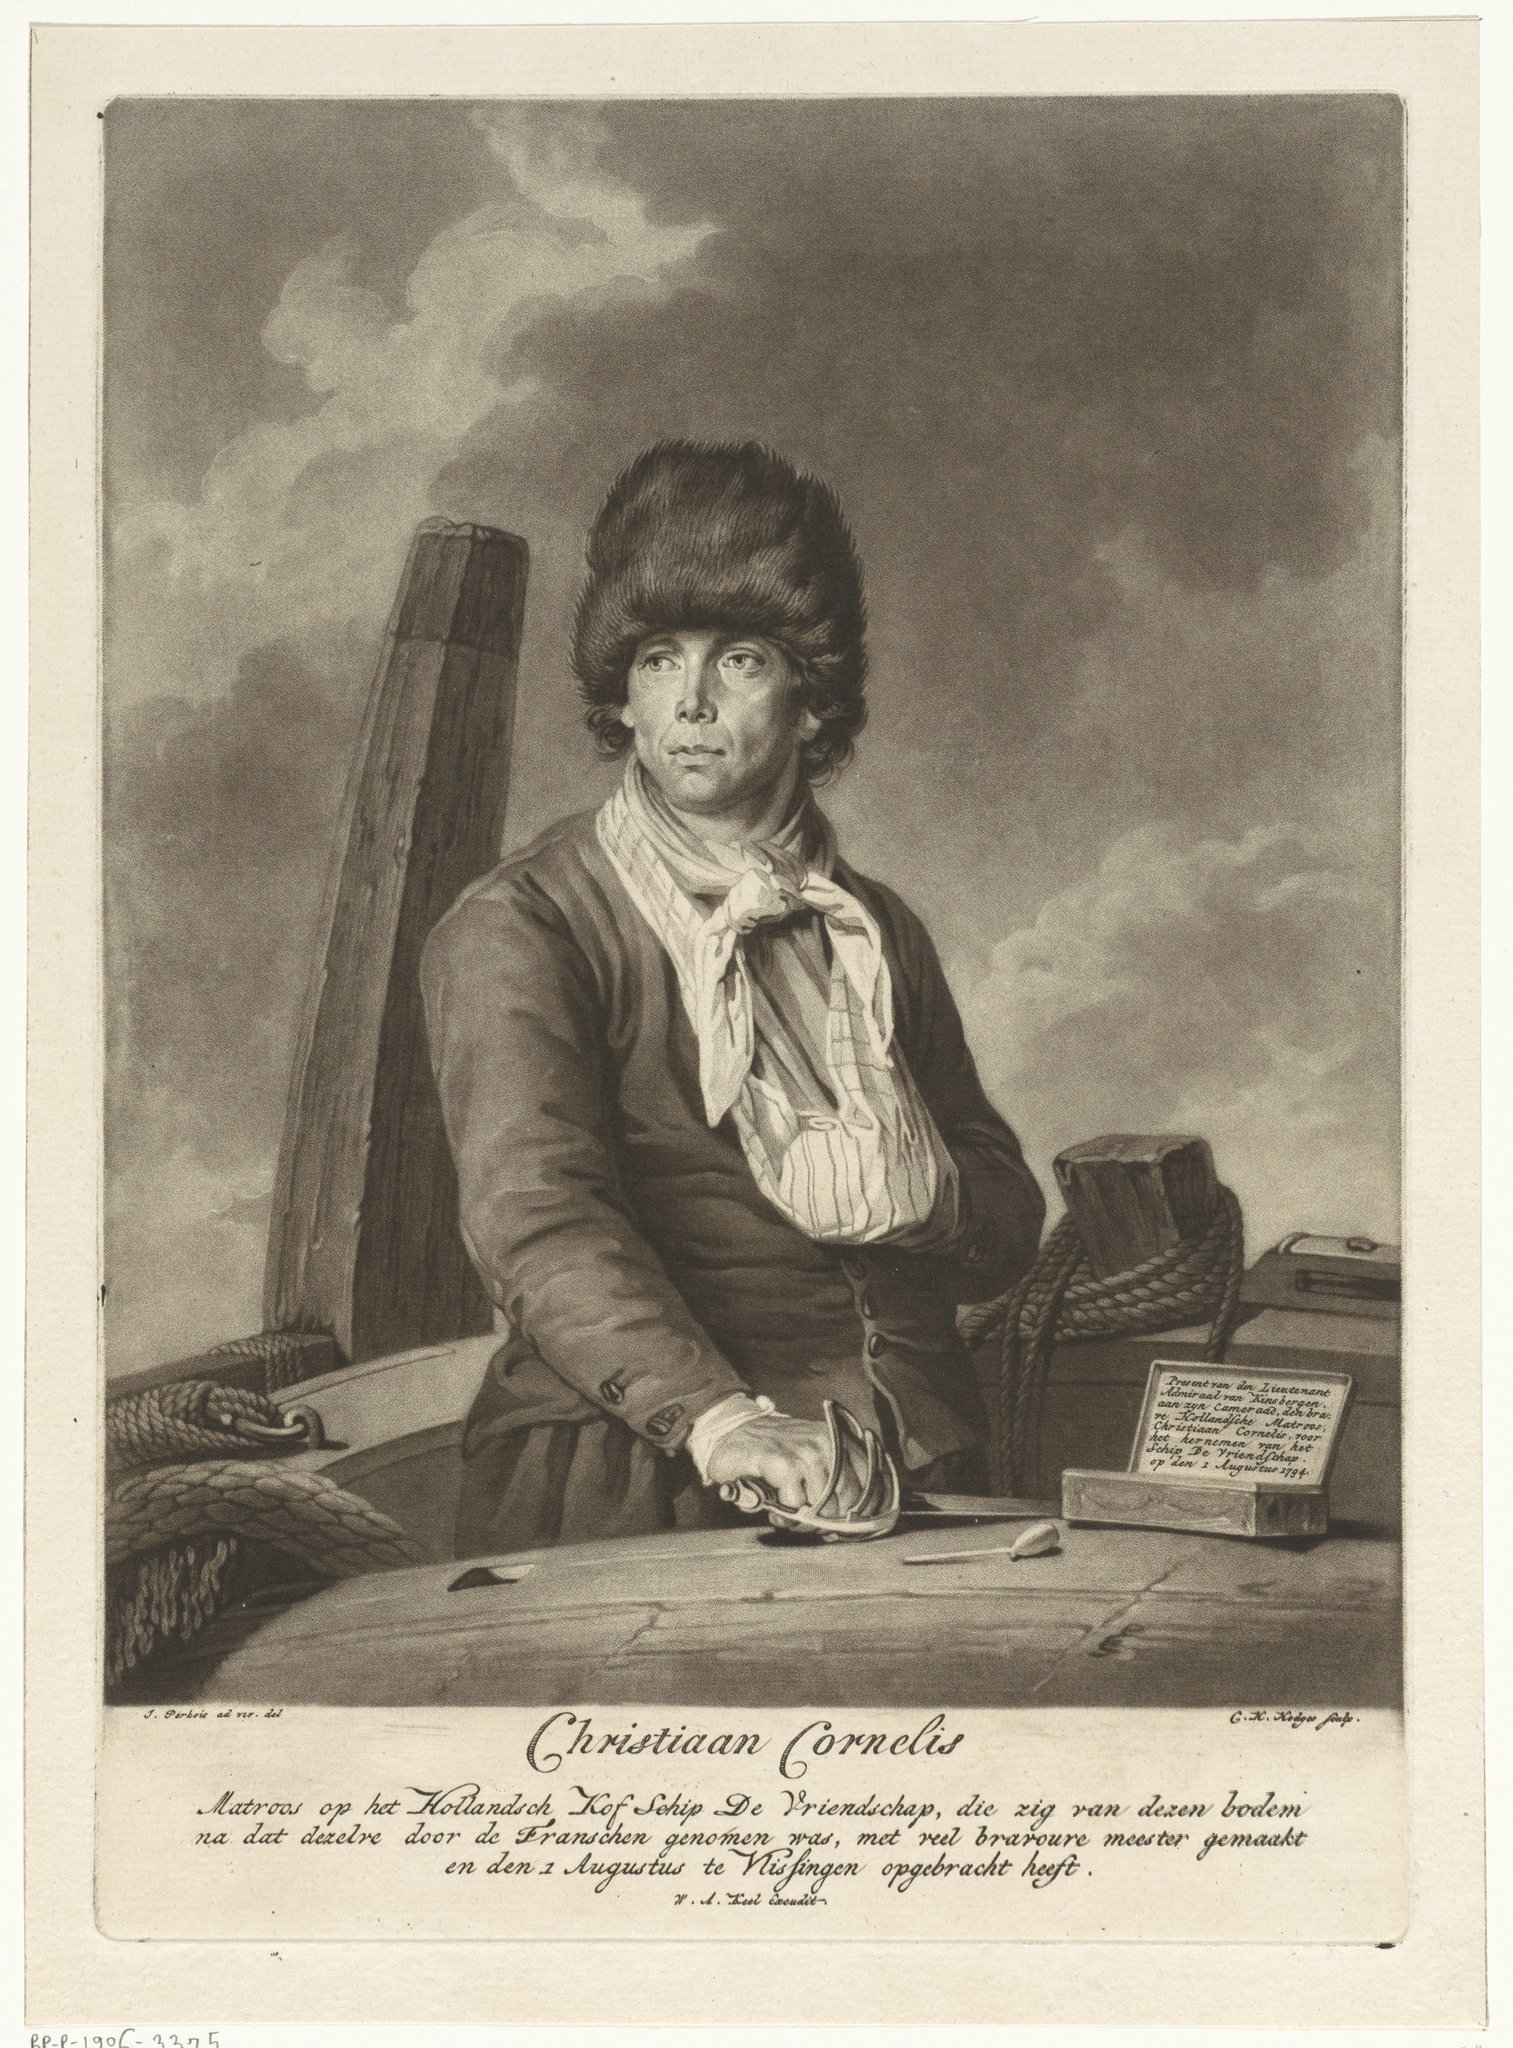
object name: print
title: Portret van Christiaan Cornelis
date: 1794-1796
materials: paper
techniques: engraving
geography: middelburg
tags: pipe ~ tobacco, parts of ship's exterior - cc - more than one ship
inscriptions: collector's mark: Lugt 2228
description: Christiaan Cornelis staat op een schip. Hij heeft zijn linkerarm in een mitella, in zijn andere een zwaard. Cornelis heroverde op 31 juli 1794 een door de Fransen ingenomen kofschip waarop hij als matroos gediend had. Nadat Cornelis het schip had teruggebracht werd hij door admiraal van Kinsbergen met een zilveren tabaksdoos beloond. Onder de afbeelding een onderschrift met betrekking tot zijn heldendaad.